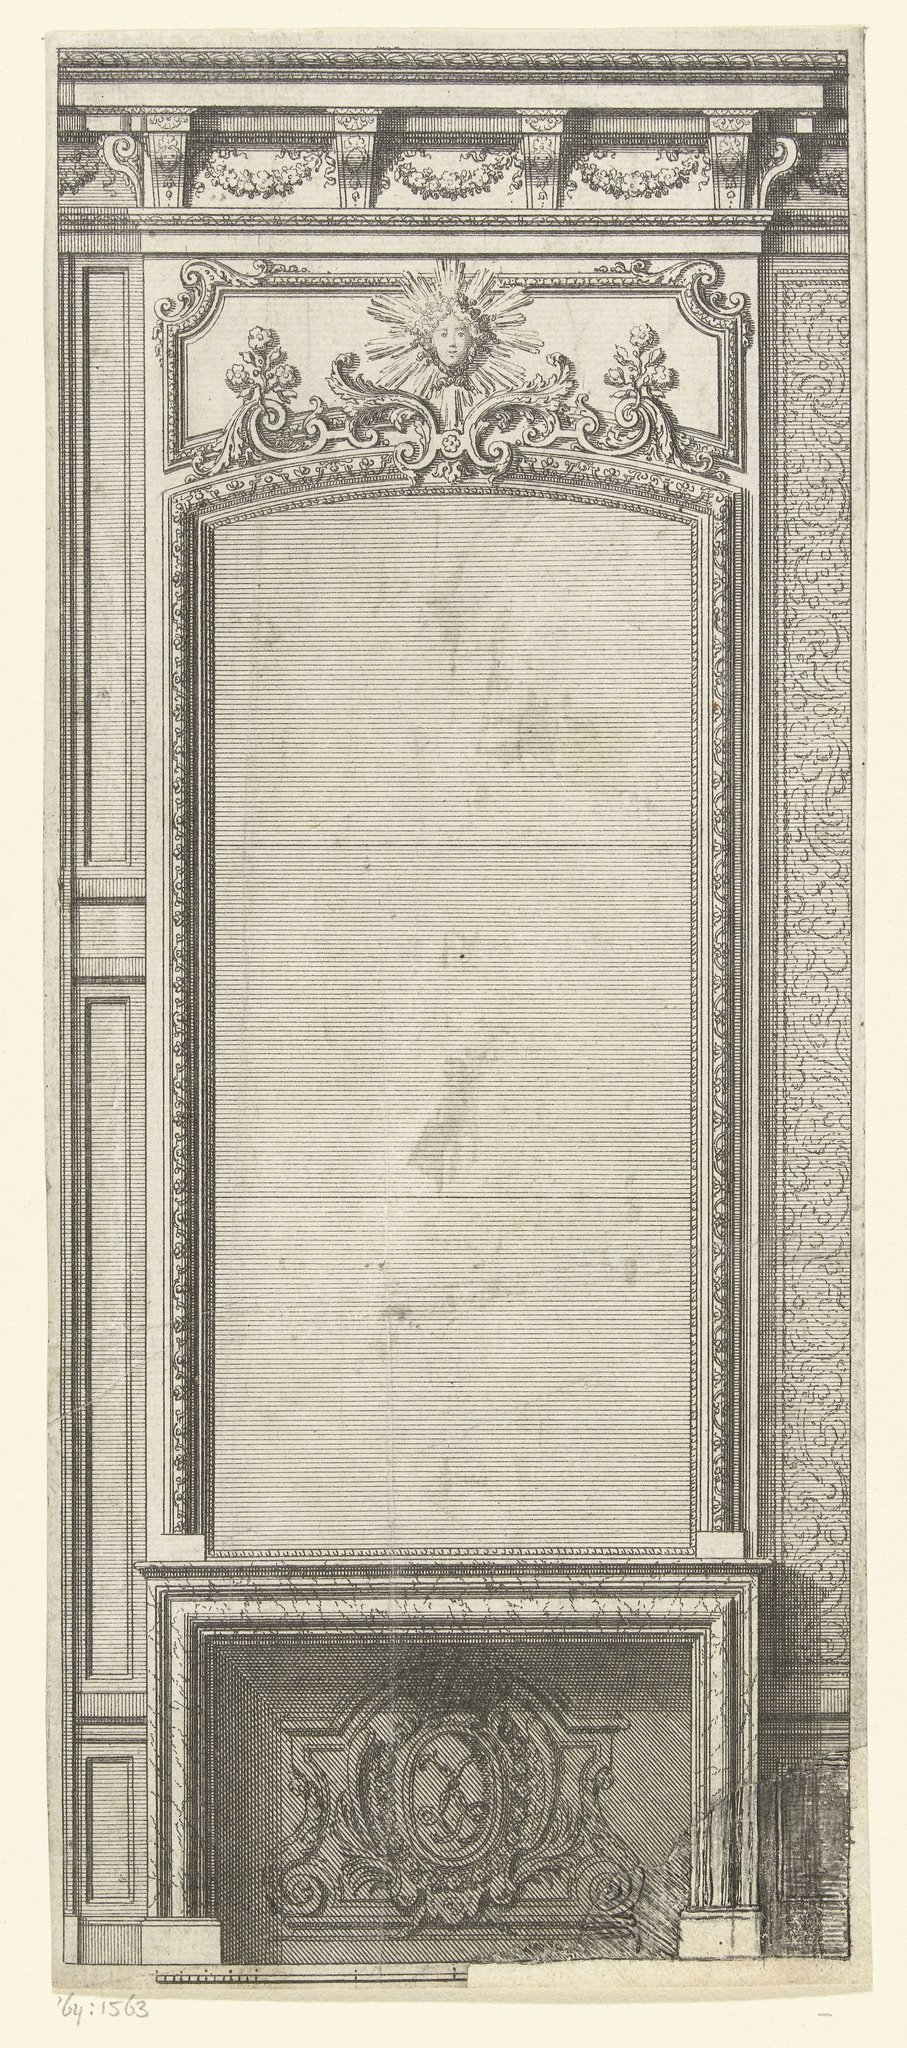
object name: print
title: Schoorsteen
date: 1670-1699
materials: paper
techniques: etching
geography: paris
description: Niet in Berlin. Guilmard. Zie Fishe Kimball, The Creation of the Rococo, p.68 (vermeld reeks in Met.Mus.N.Y. als uniek). Zie ook: Metrop.Mus. Studies, Vol. V, p.274 e.v.